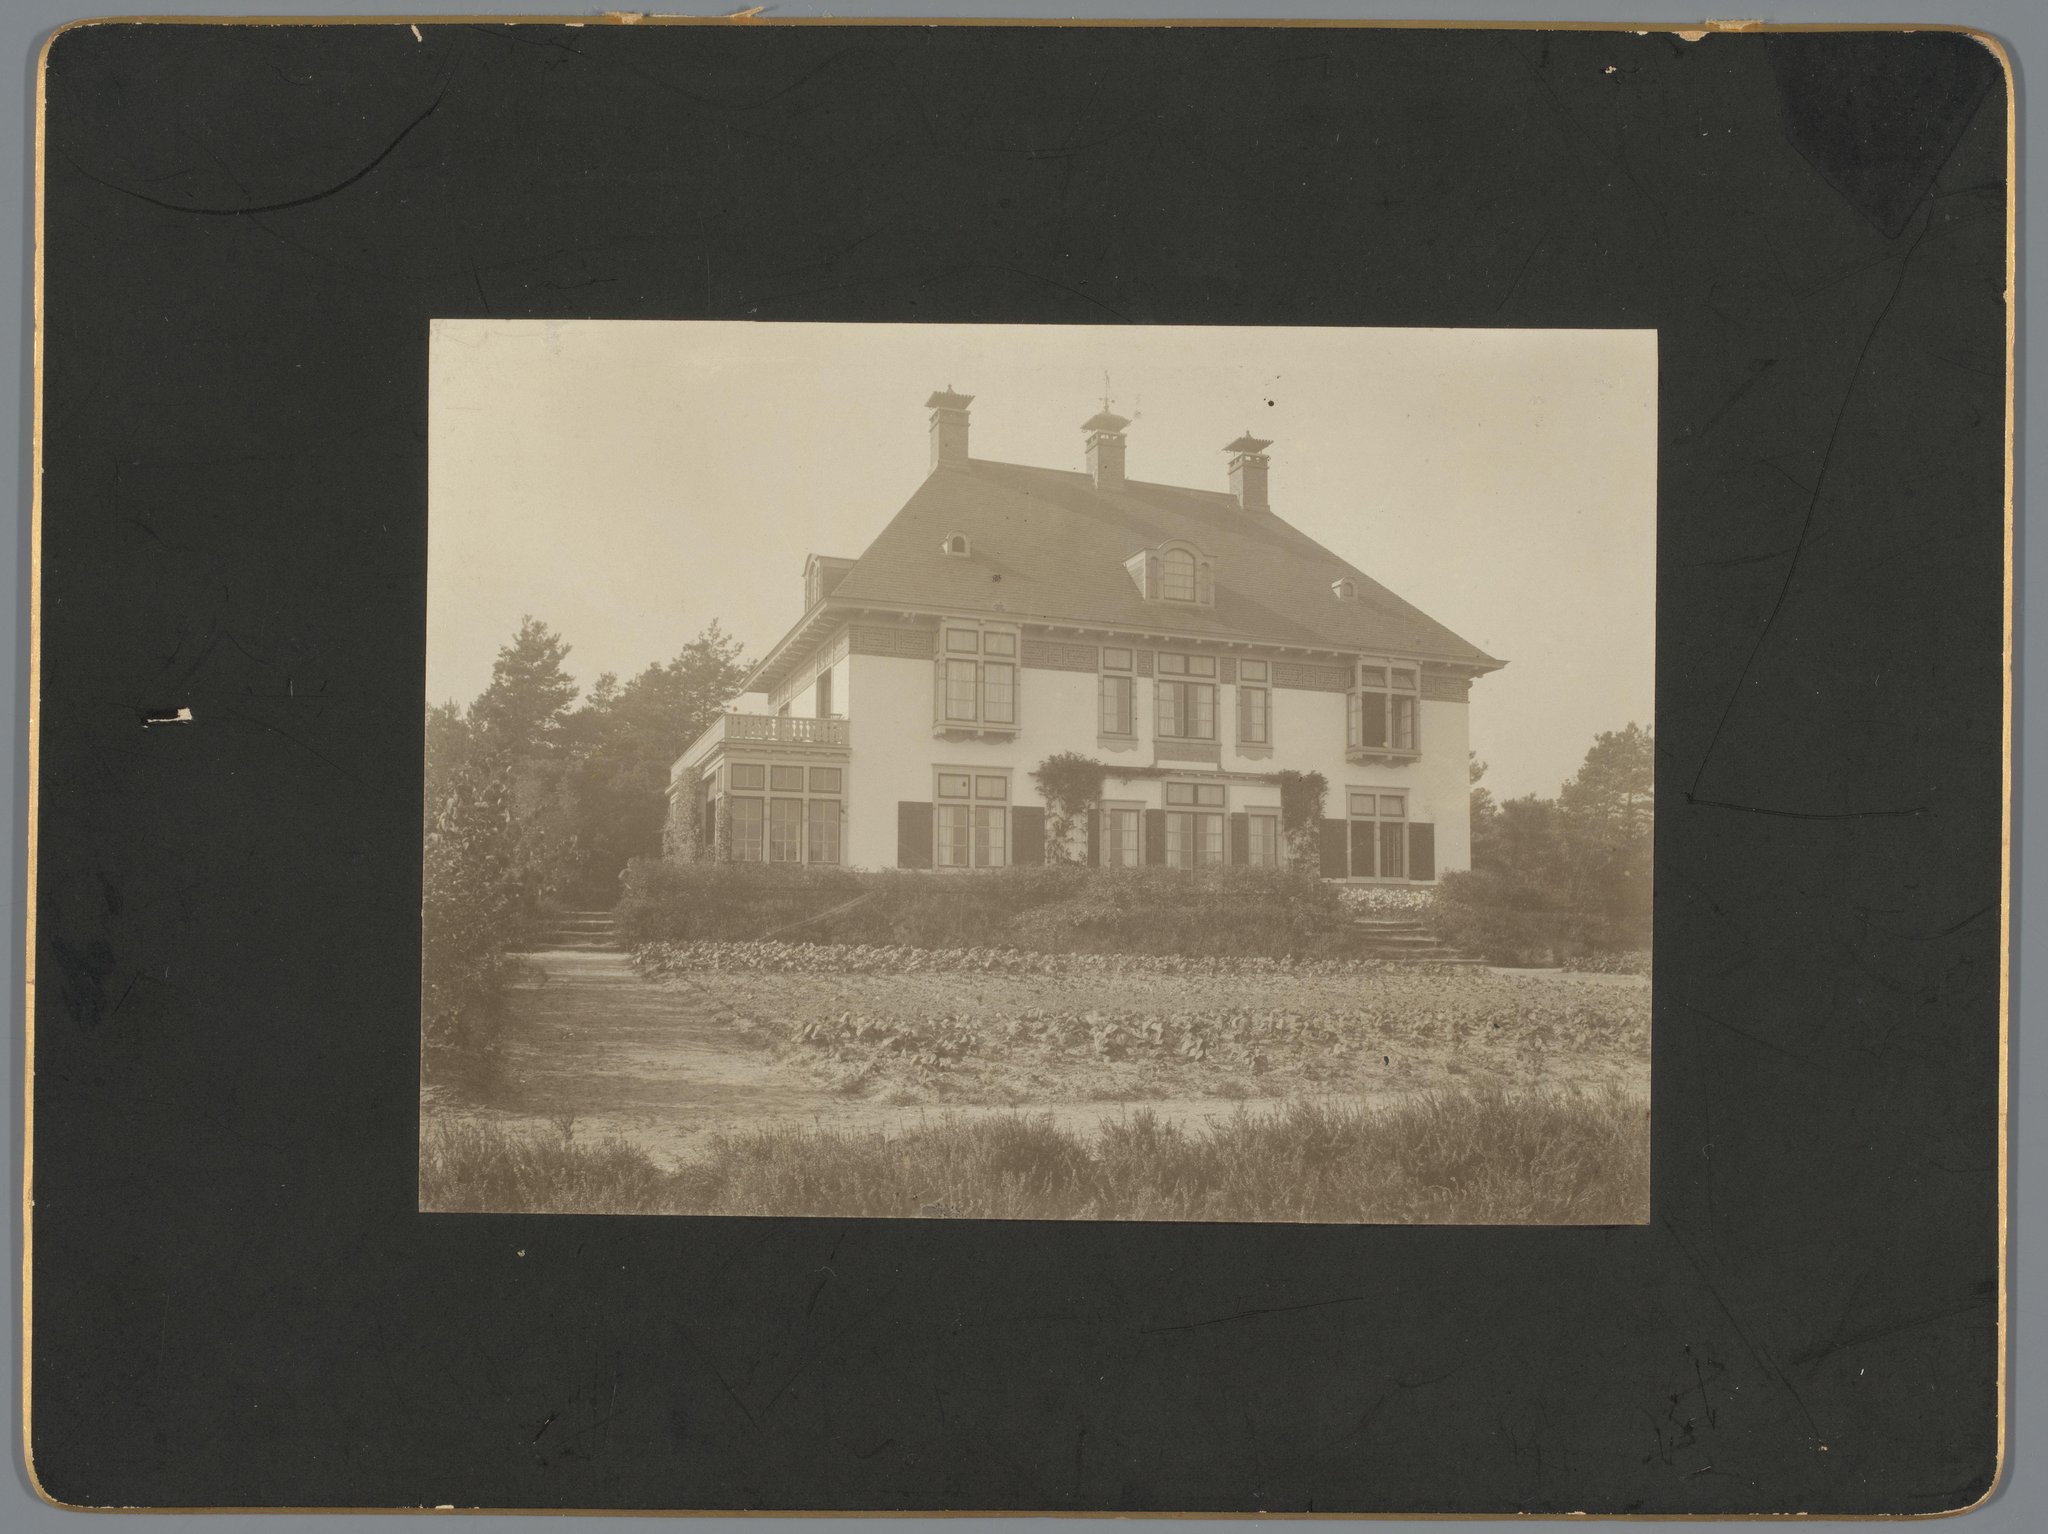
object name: photograph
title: Gezicht op 't Veldhuys aan de Veldweg te Hattem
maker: cornelia hendrika jonker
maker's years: 1874-1924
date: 1900-1940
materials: cardboard, photographic support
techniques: gelatin silver print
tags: garden, façade (of house or building)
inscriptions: annotation: ‘A.’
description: 't Veldhuys aan de Veldweg te Hattem, ontwerp van K.P.C. de Bazel.